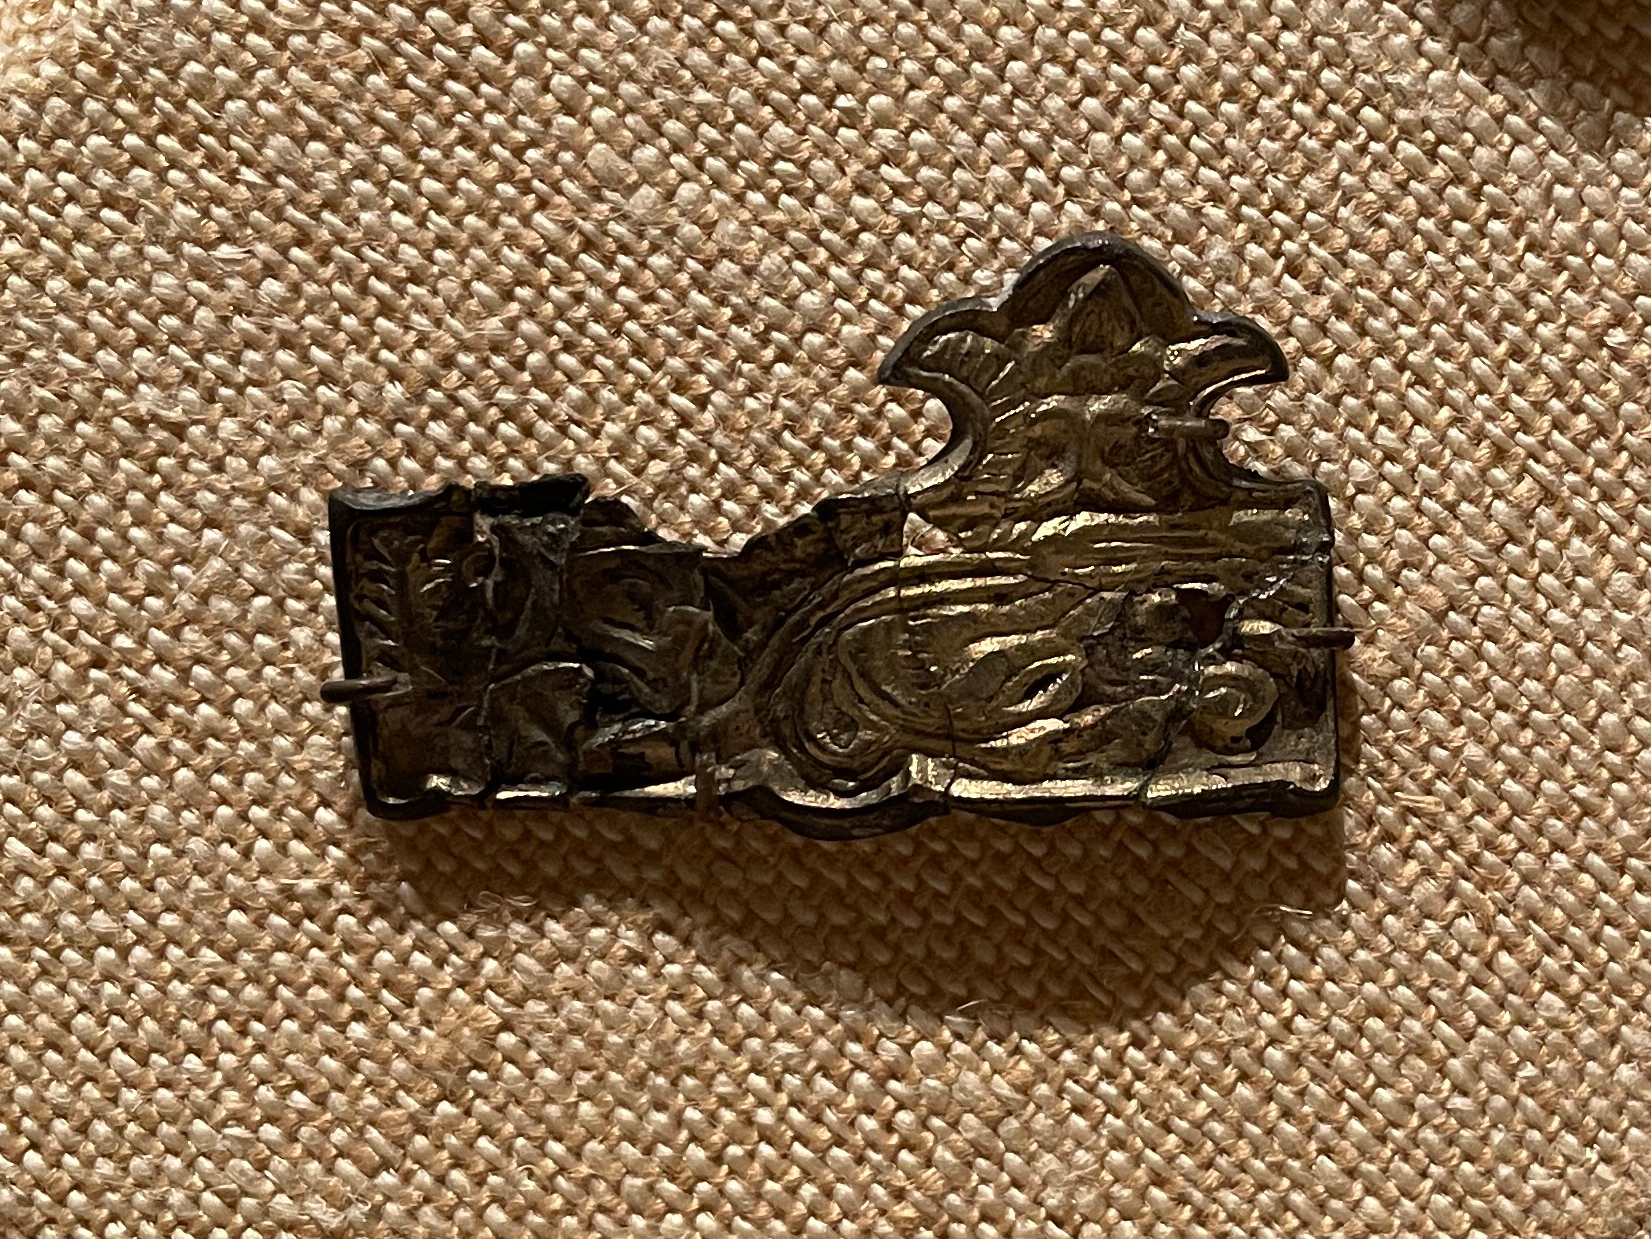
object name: belt fitting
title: Belt Fittings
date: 701-1000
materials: silver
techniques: casting, gilding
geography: iran